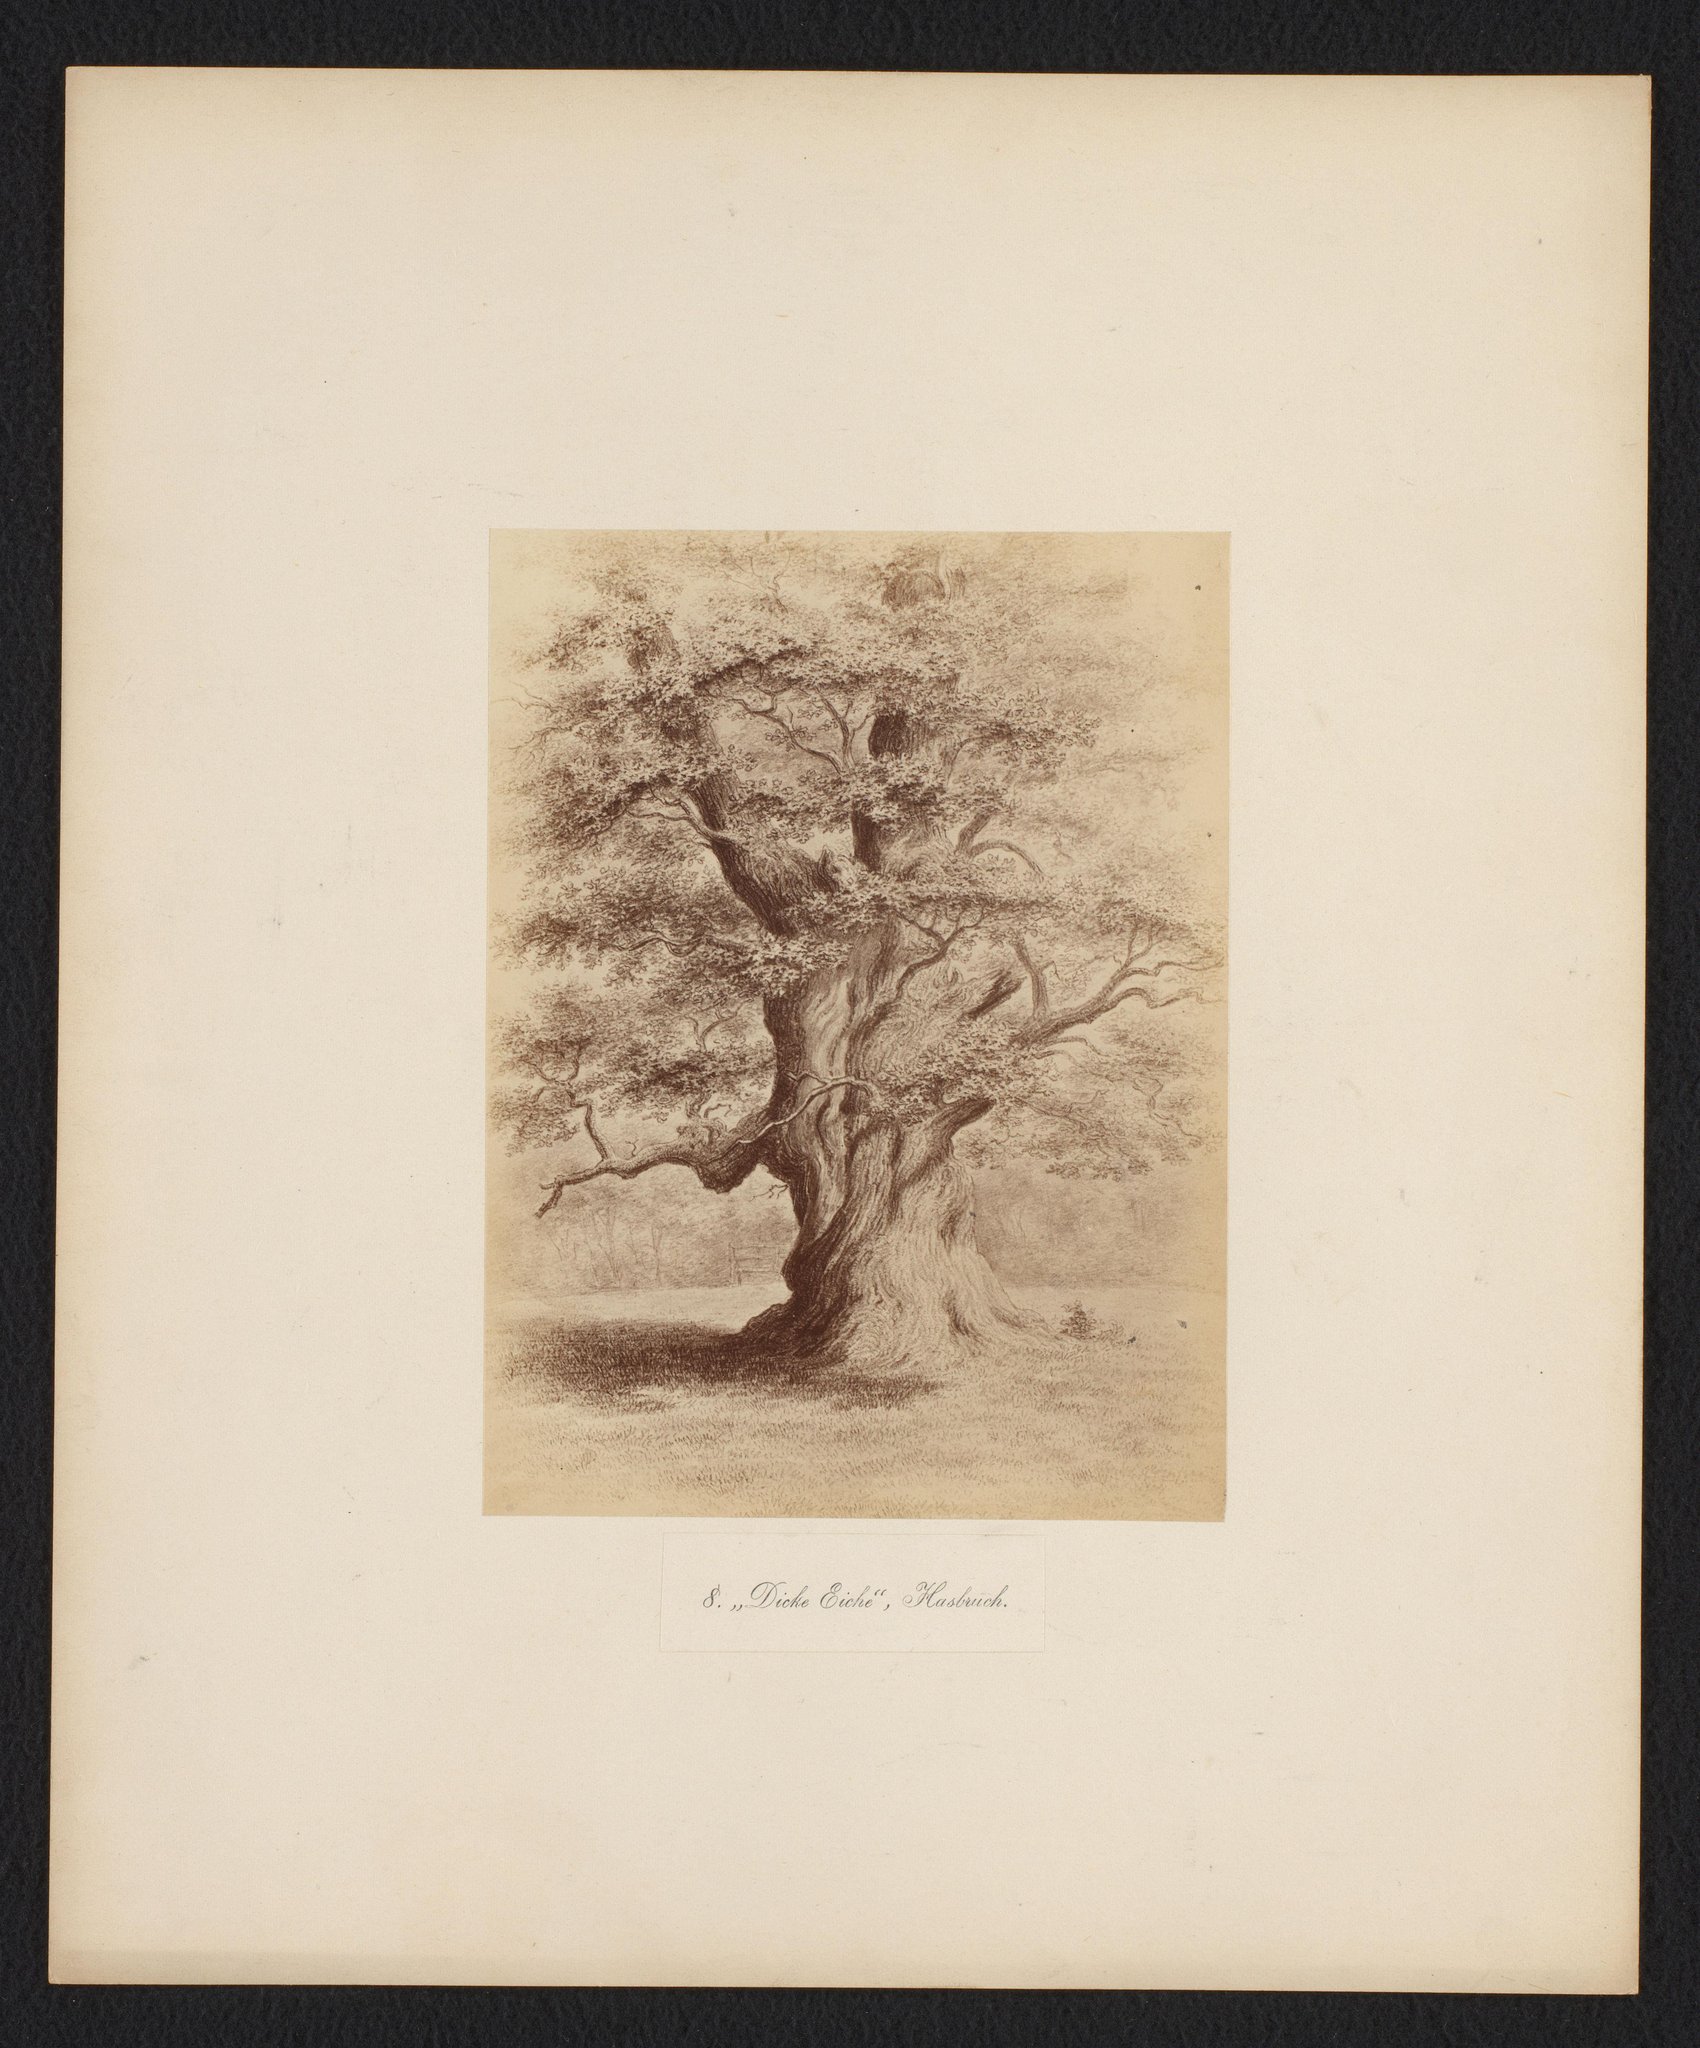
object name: photograph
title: 8. "Dicke Eiche", Hasbruch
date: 1870-1875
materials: cardboard, paper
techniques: albumen print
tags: trees: oak